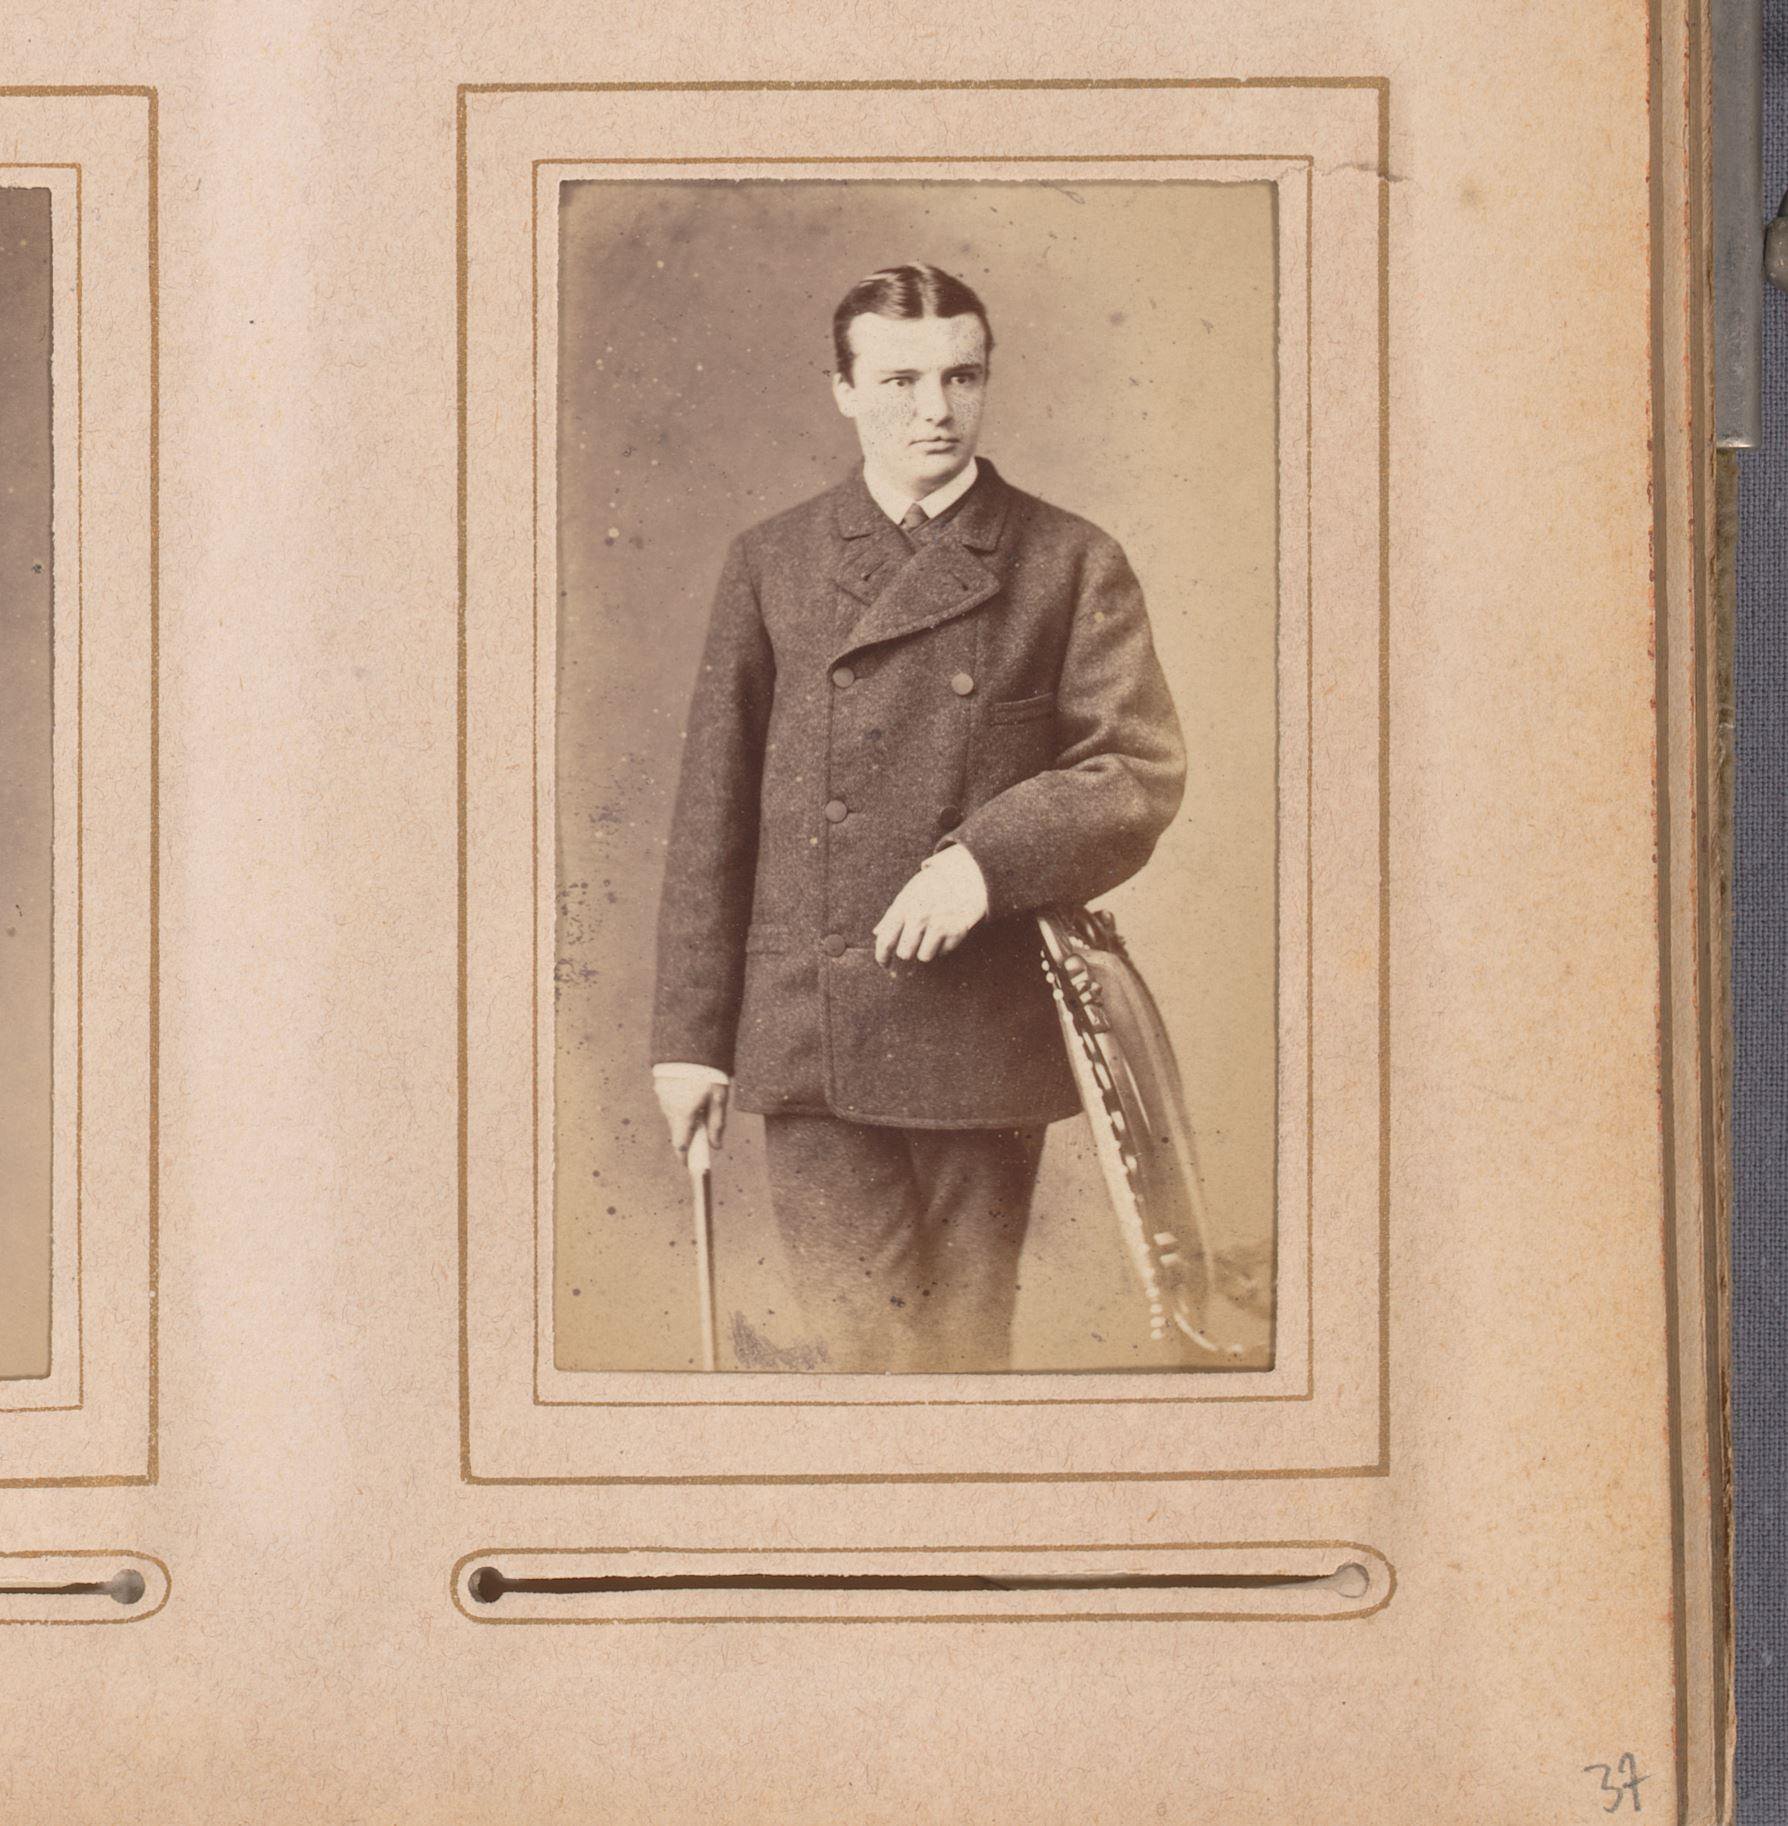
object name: photograph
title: Portret van een man met wandelstok, staand bij een stoel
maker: johan christiaan reesinck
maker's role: fotograaf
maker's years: 1838-1922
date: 1863-1900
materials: cardboard, photographic support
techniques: albumen print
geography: netherlands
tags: standing figure, walking-stick, staff, historical persons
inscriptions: inscription: ‘J.C. Reesinck/ photograaf/ Zutphen en Deventer’